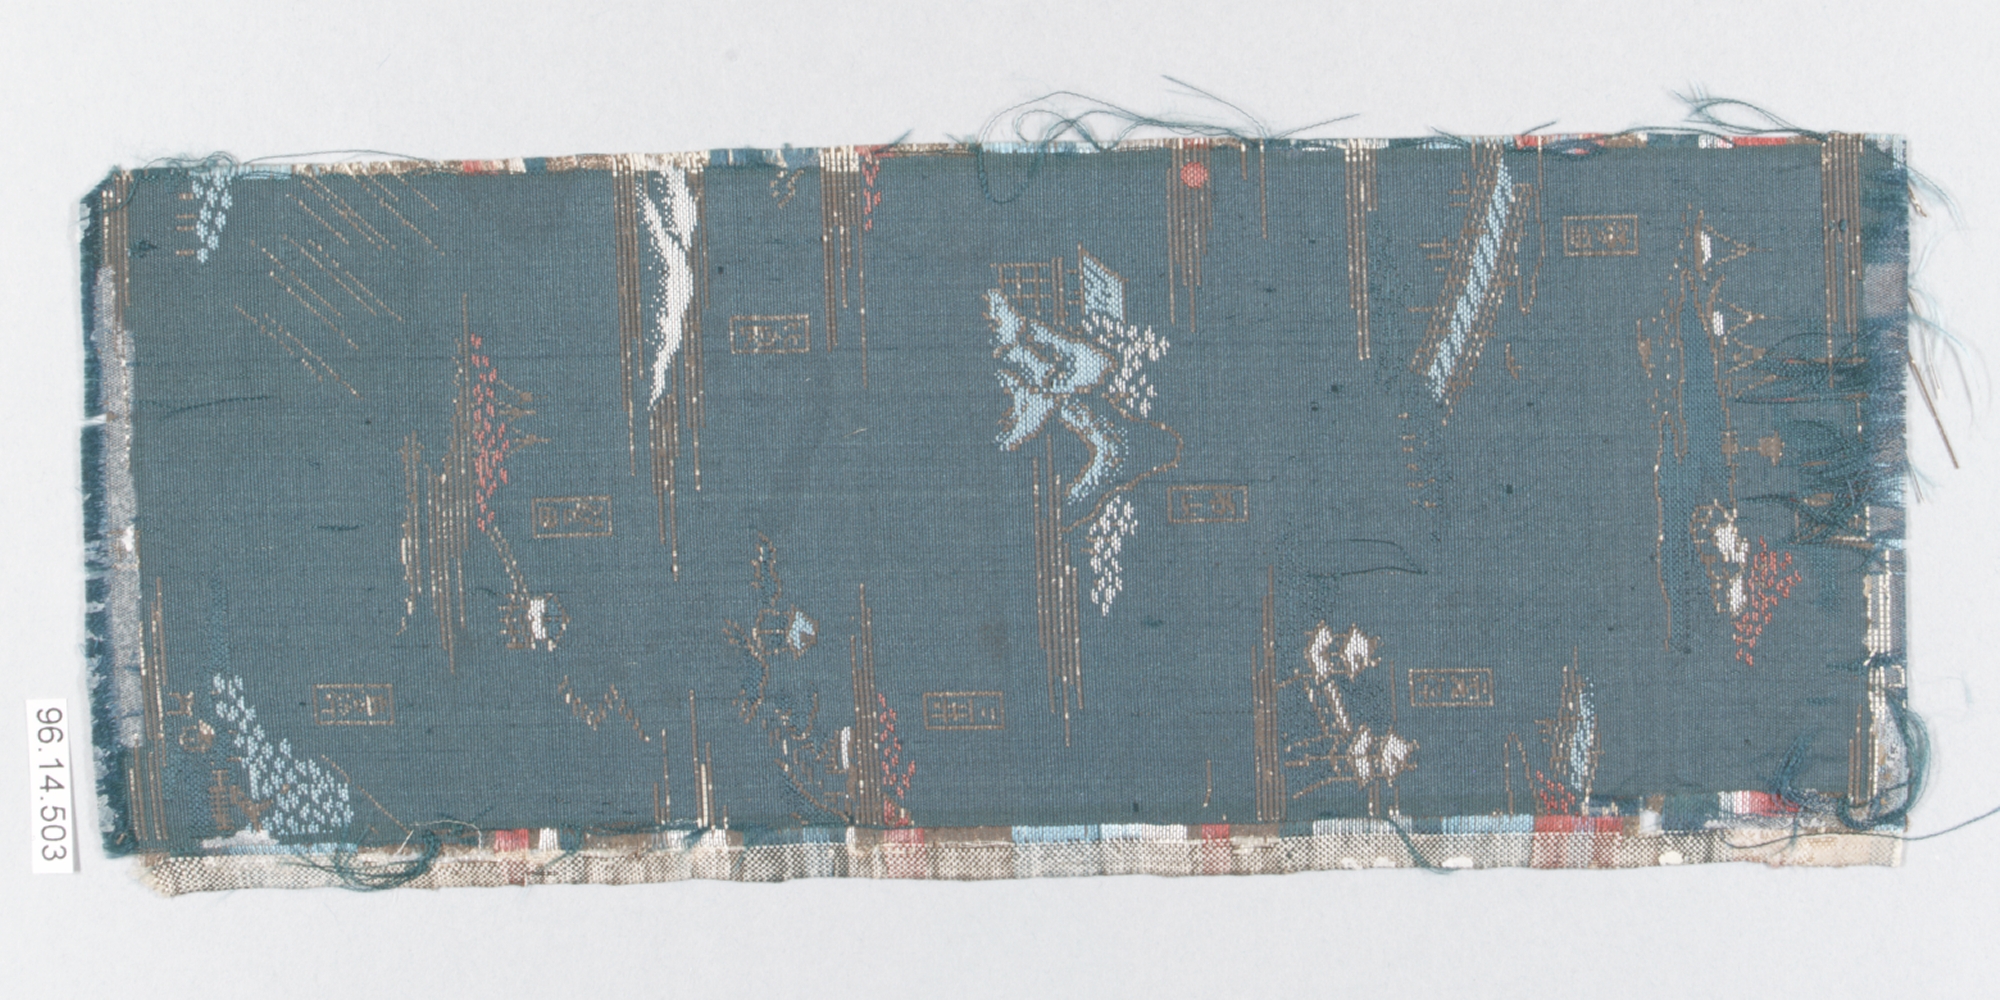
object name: piece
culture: japanese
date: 1801-1833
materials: metal thread, silk